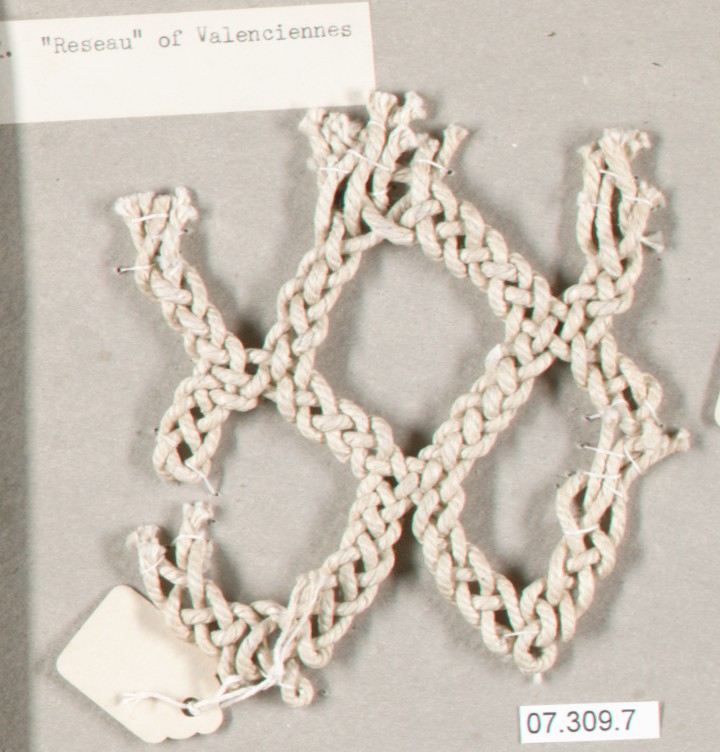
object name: stitch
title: Example of lace stitch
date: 1801-2000